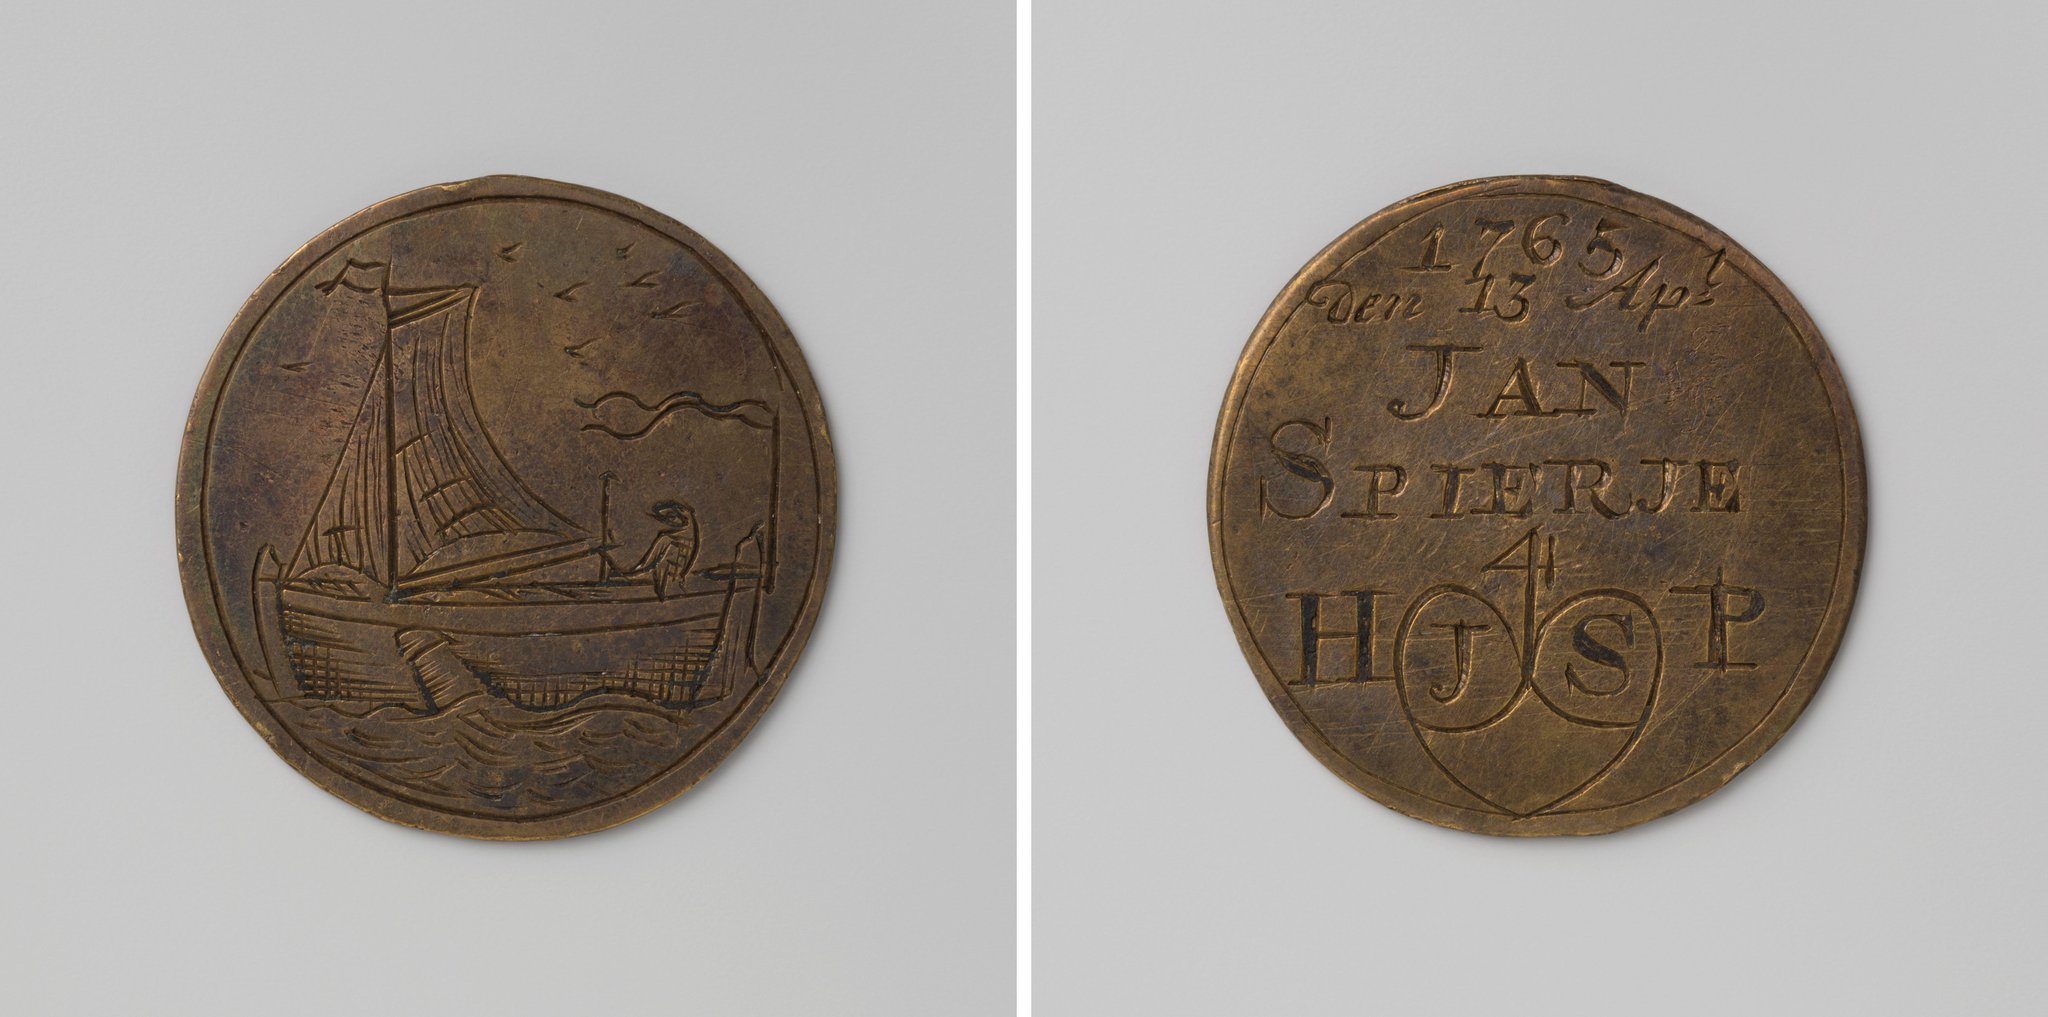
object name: medal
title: Roei-, steiger- en schuitenvoerdersgilde van Amsterdam, gildepenning van Jan Spierje, ligplaats Haringpakkerij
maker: Anonymous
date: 1765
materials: brass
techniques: engraving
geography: amsterdam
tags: amsterdam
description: Guilds were urban organisations of people in specific occupations. The guild represented the interests of the profession. Each member had a token as proof of membership. The person’s name was engraved on one side of the token, often together with the arms of the guild or of the city in which it was based. The other side carried a motif signifying the occupation represented by the guild.